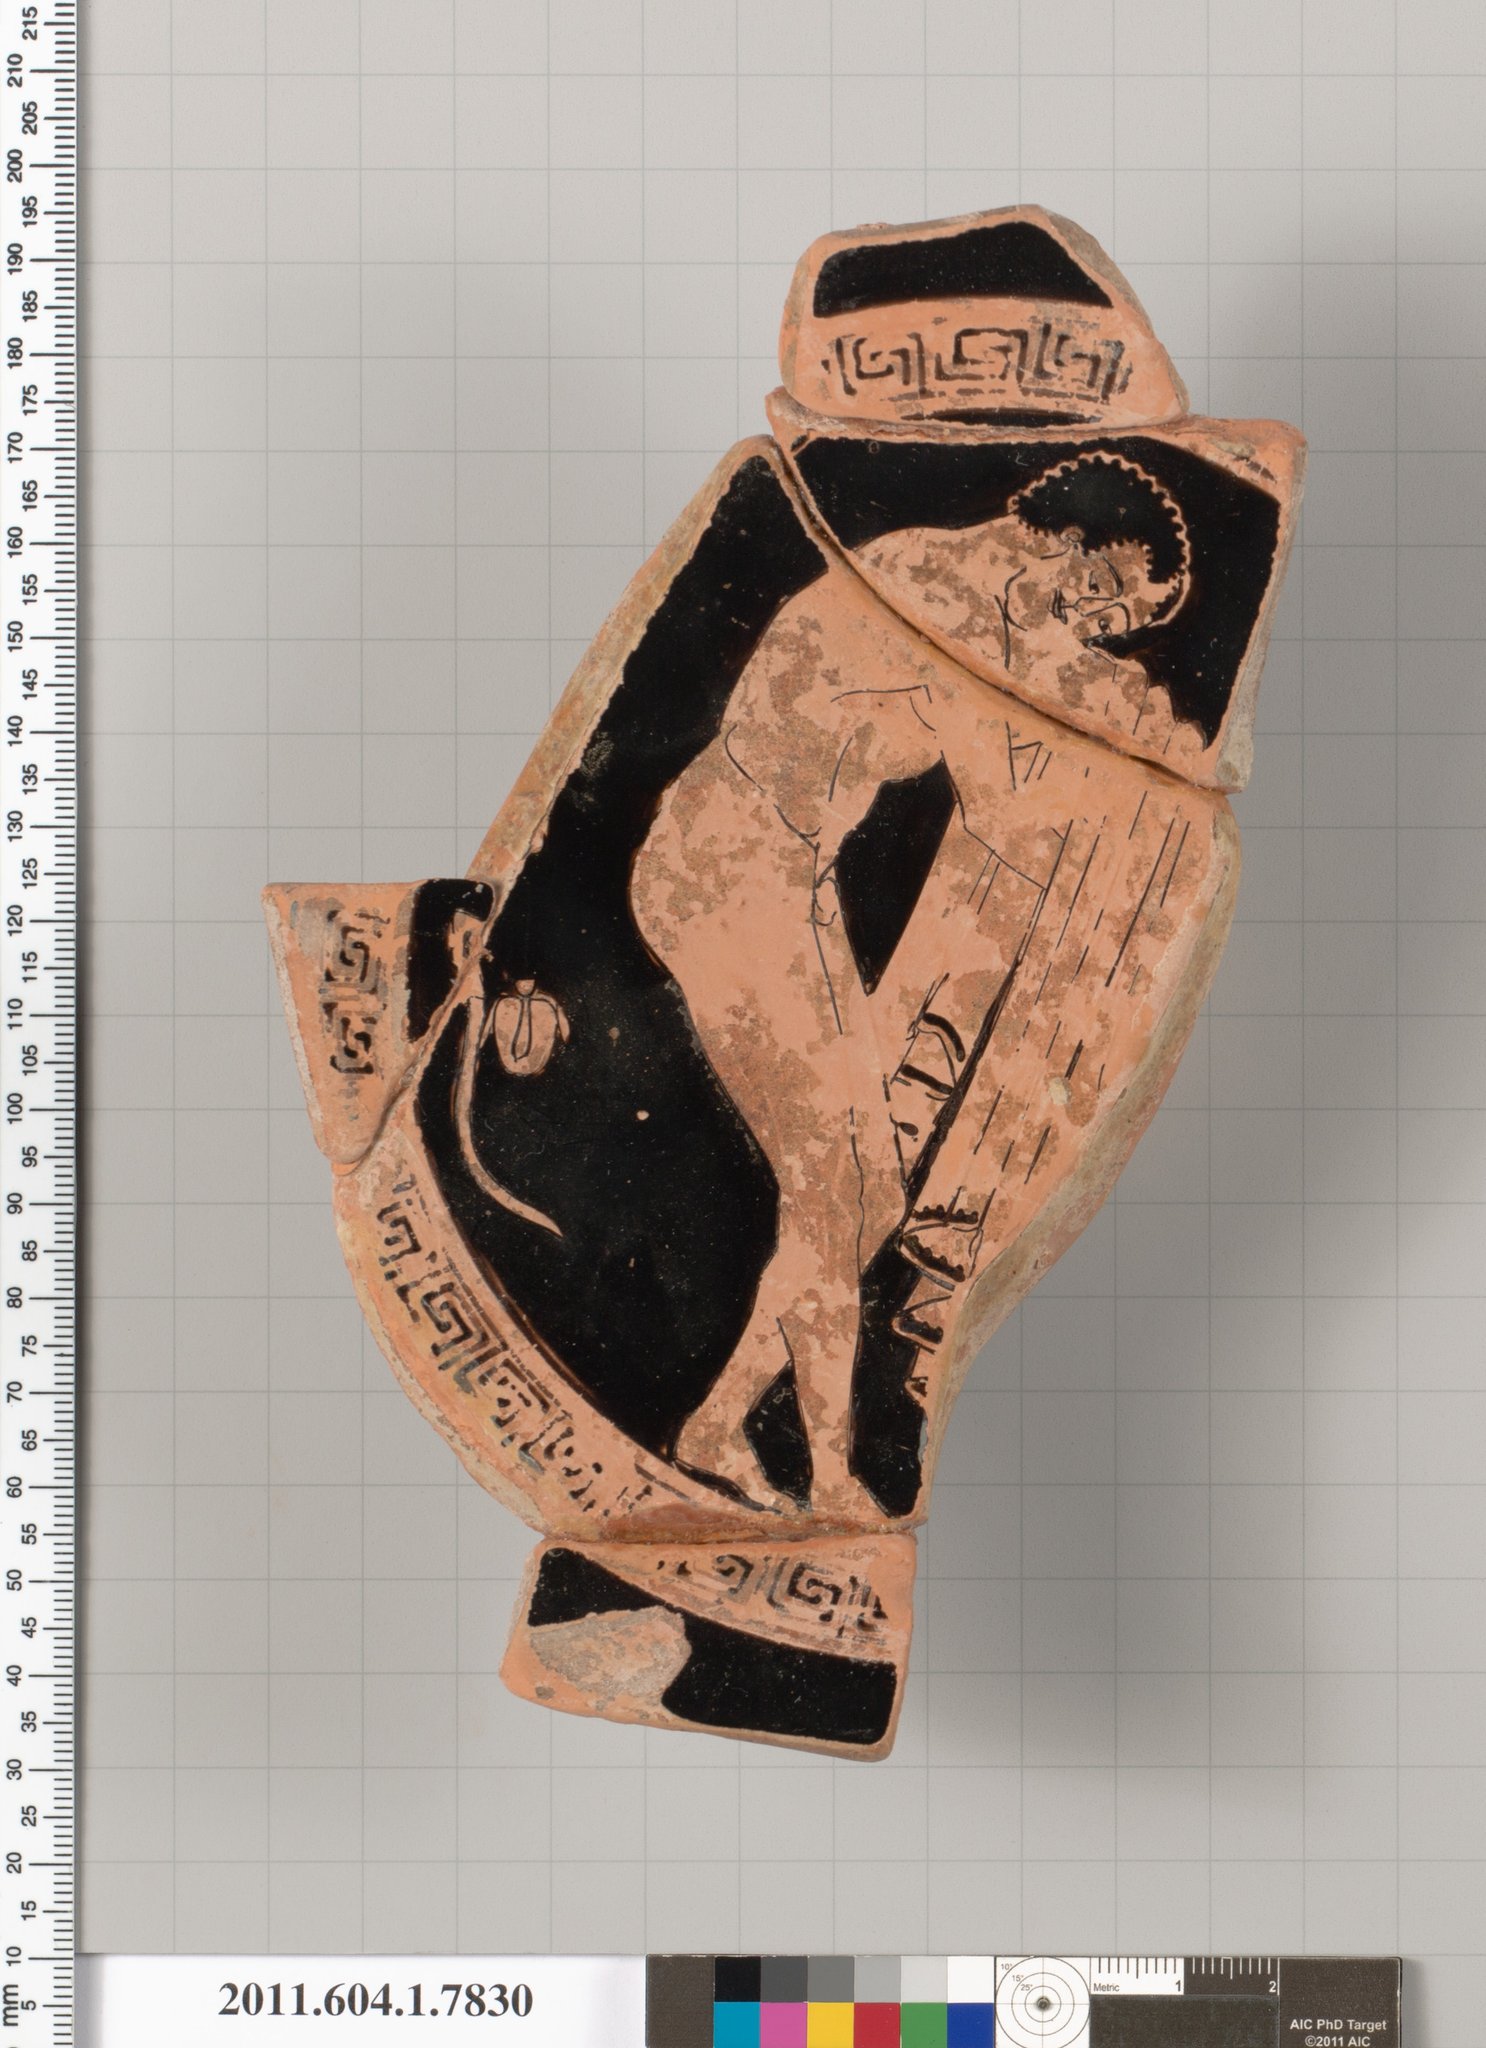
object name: kylix fragment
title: Terracotta fragment of a kylix (drinking cup)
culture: greek, attic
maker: foundry painter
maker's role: artist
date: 480-470 BCE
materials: terracotta